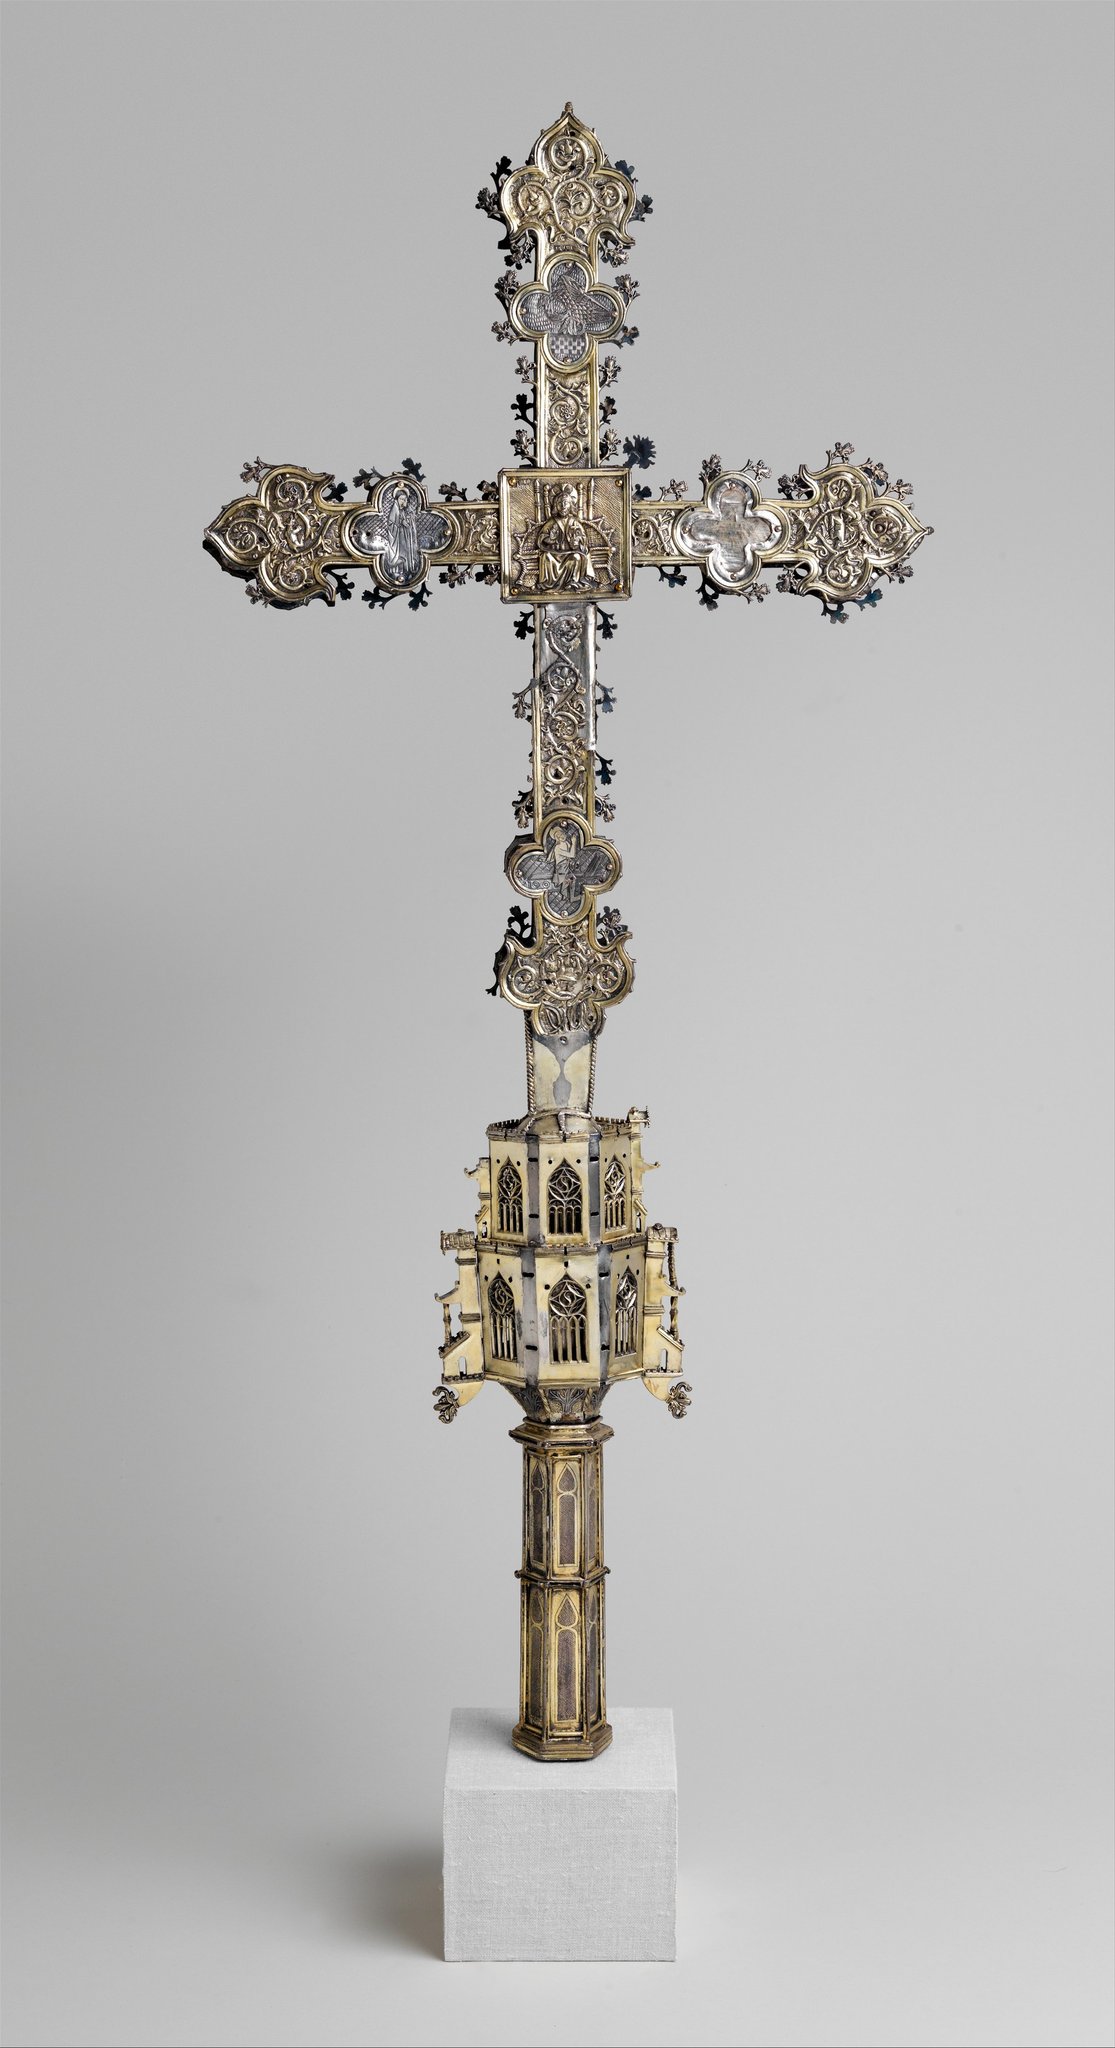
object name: cross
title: Processional Cross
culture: spanish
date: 1450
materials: enamel, silver gilt, wood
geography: spain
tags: christ,virgin mary,adam,evangelists